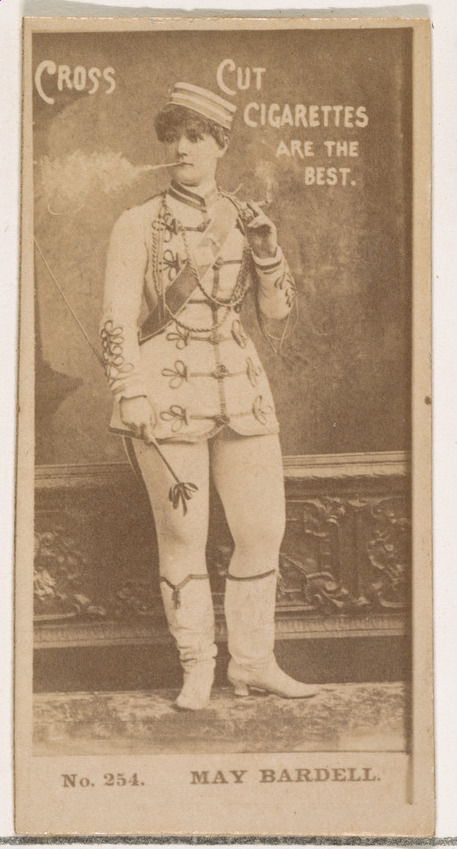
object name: print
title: Card Number 254, May Bardell, from the Actors and Actresses series (N145-2) issued by Duke Sons & Co. to promote Cross Cut Cigarettes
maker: w. duke, sons & co.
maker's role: publisher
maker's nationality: american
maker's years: 1870-1920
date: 1880-1889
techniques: albumen silver print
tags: portraits,women,actresses